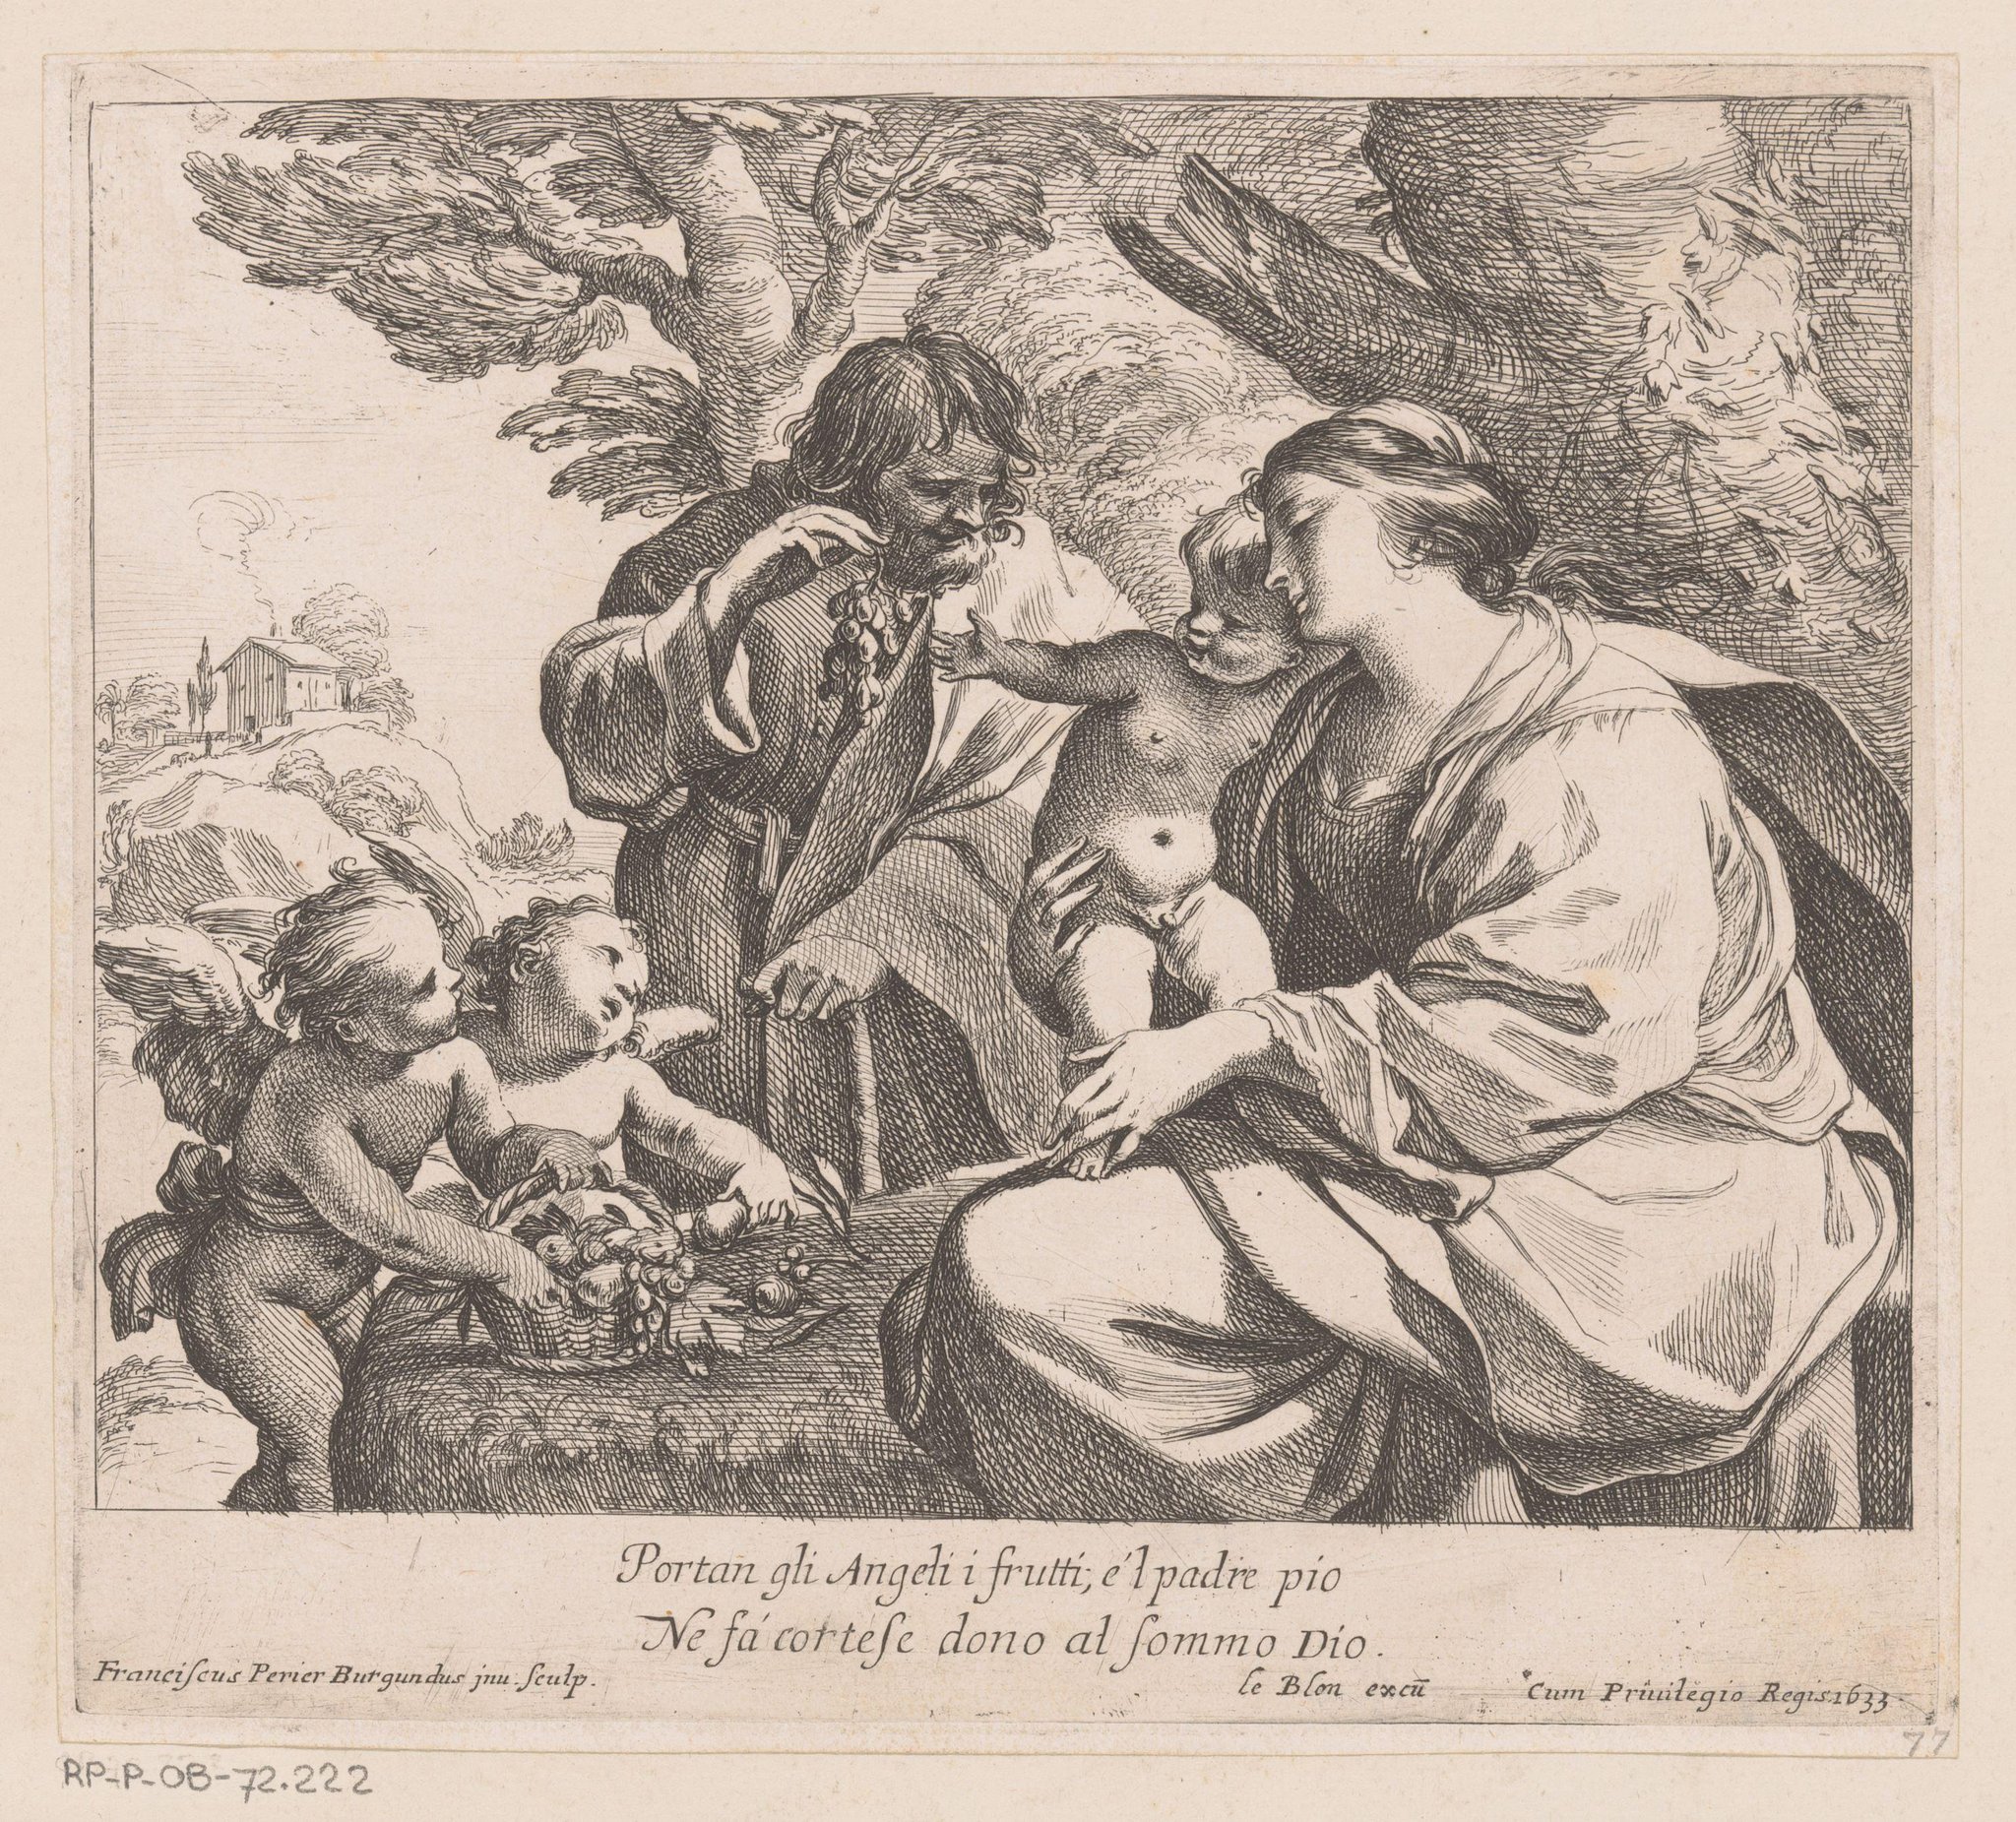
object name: print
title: Portan gli Angeli i frutti (...)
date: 1633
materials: paper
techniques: etching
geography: france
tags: holy family, and derived representations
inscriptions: collector's mark: Lugt 240